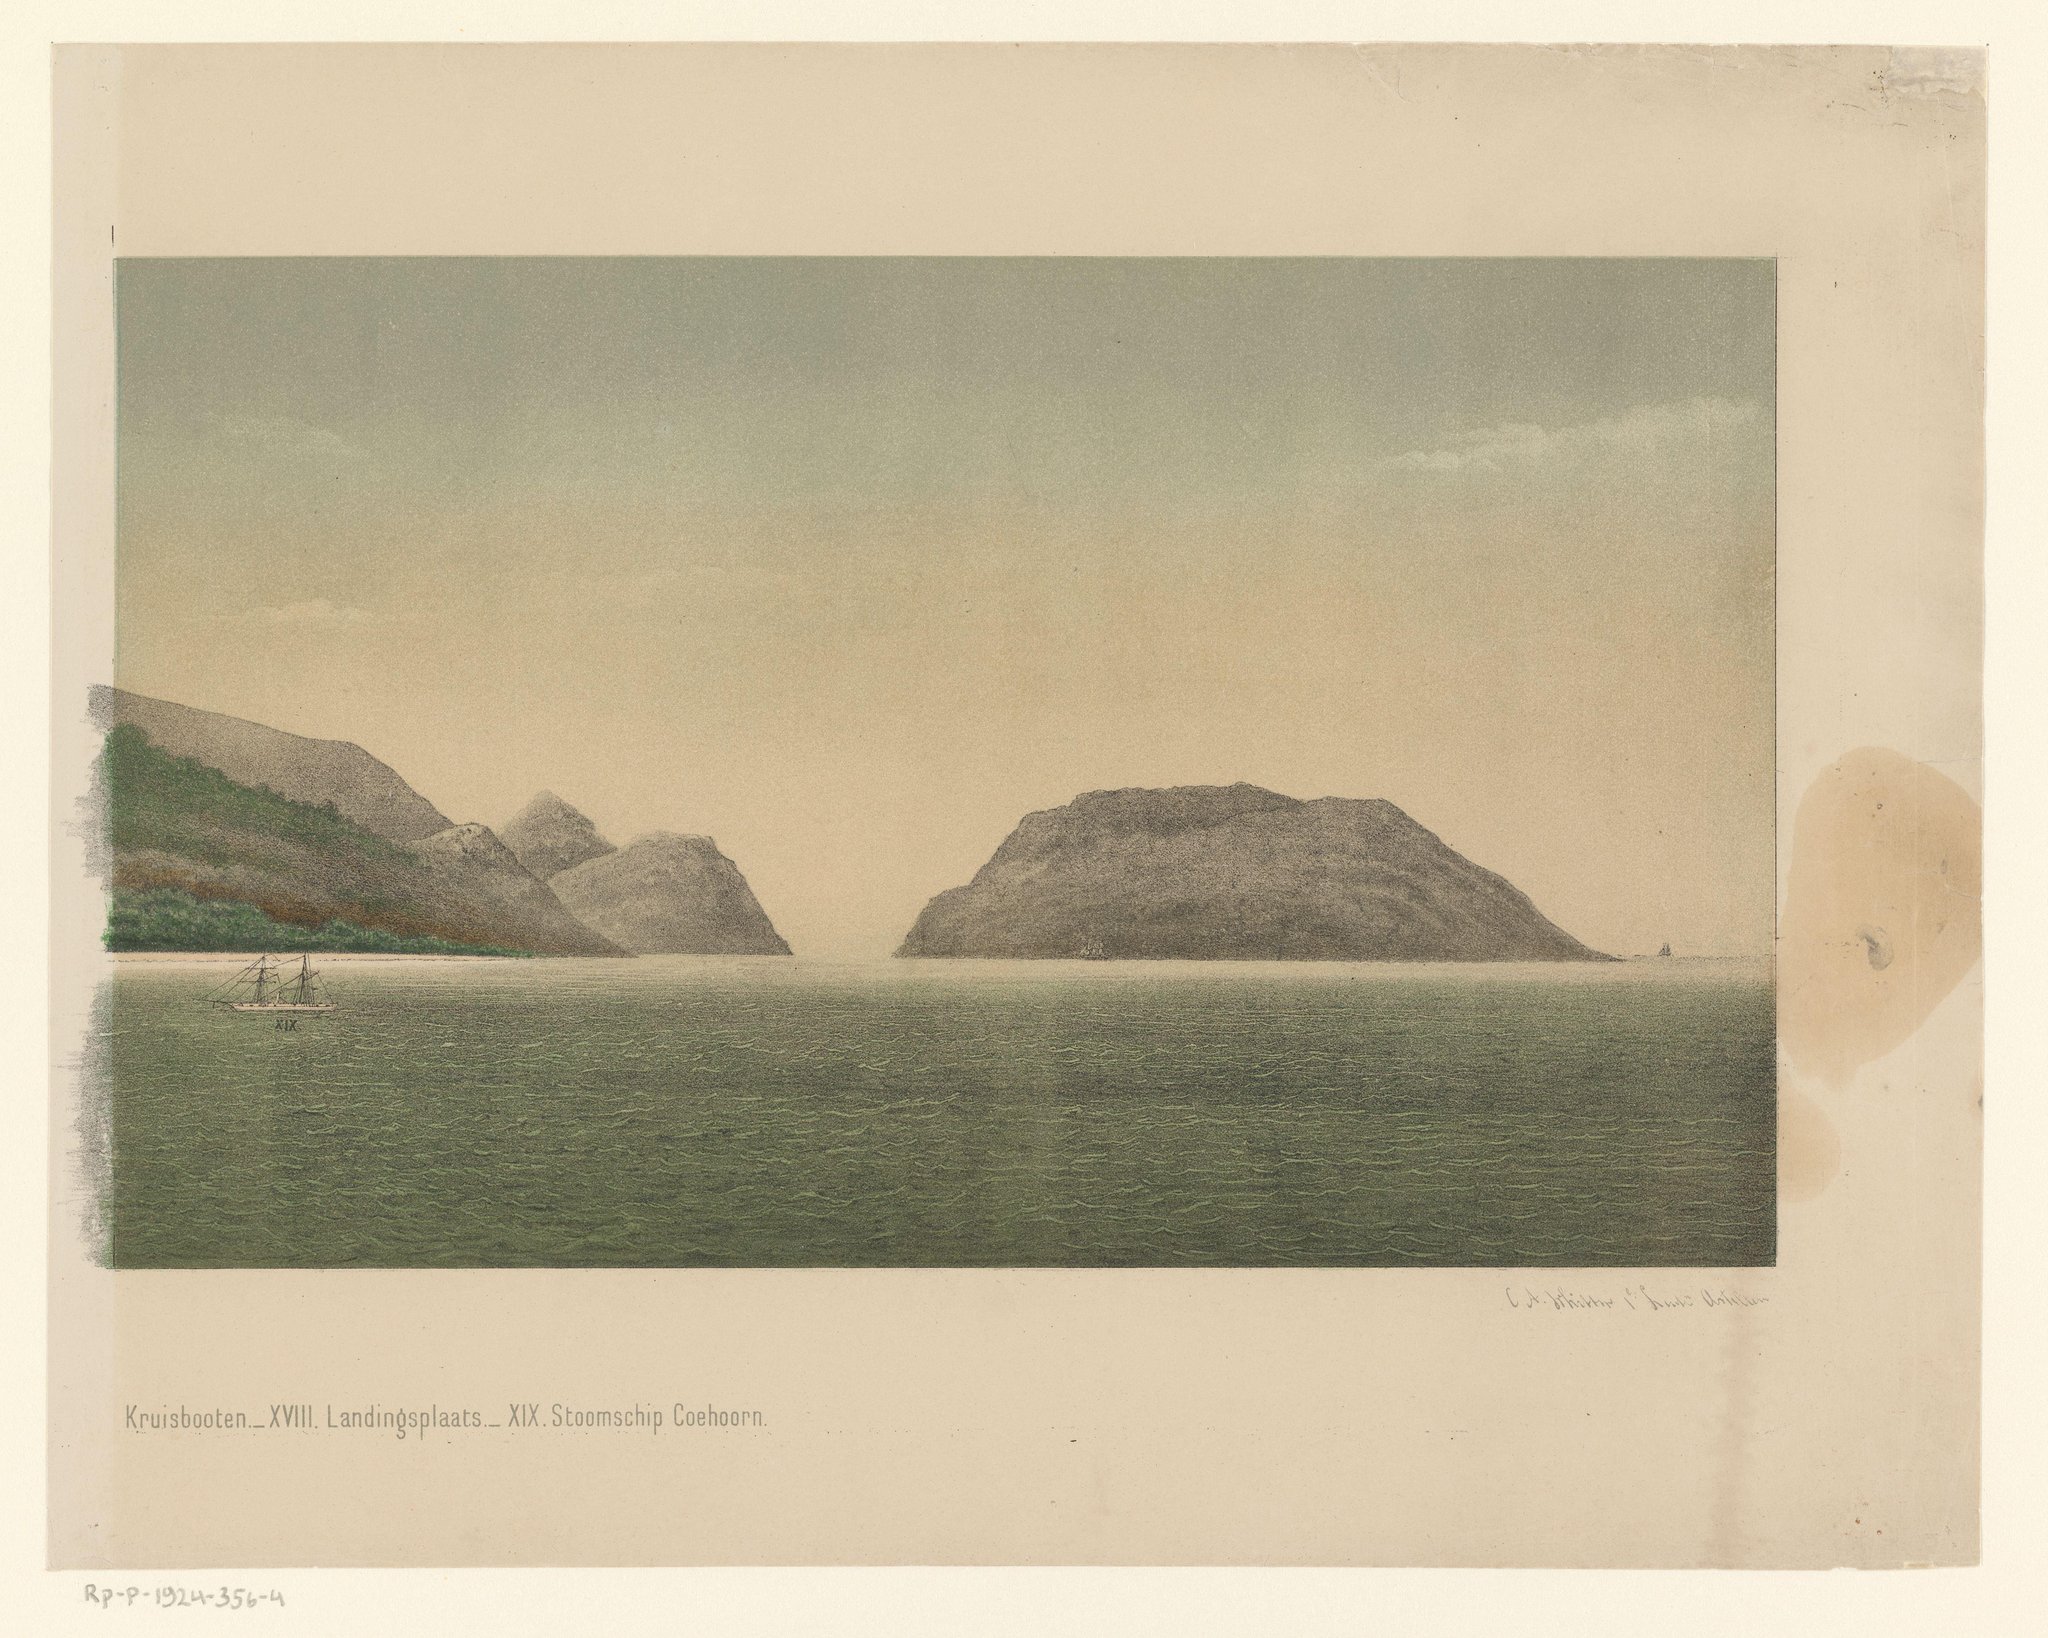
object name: print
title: De reede van Groot-Atjeh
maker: c.a. whitten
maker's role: print maker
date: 1873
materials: paper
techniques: lithograph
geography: the hague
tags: ships (in general) - cc - more than one ship, coast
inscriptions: collector's mark: Lugt 2228